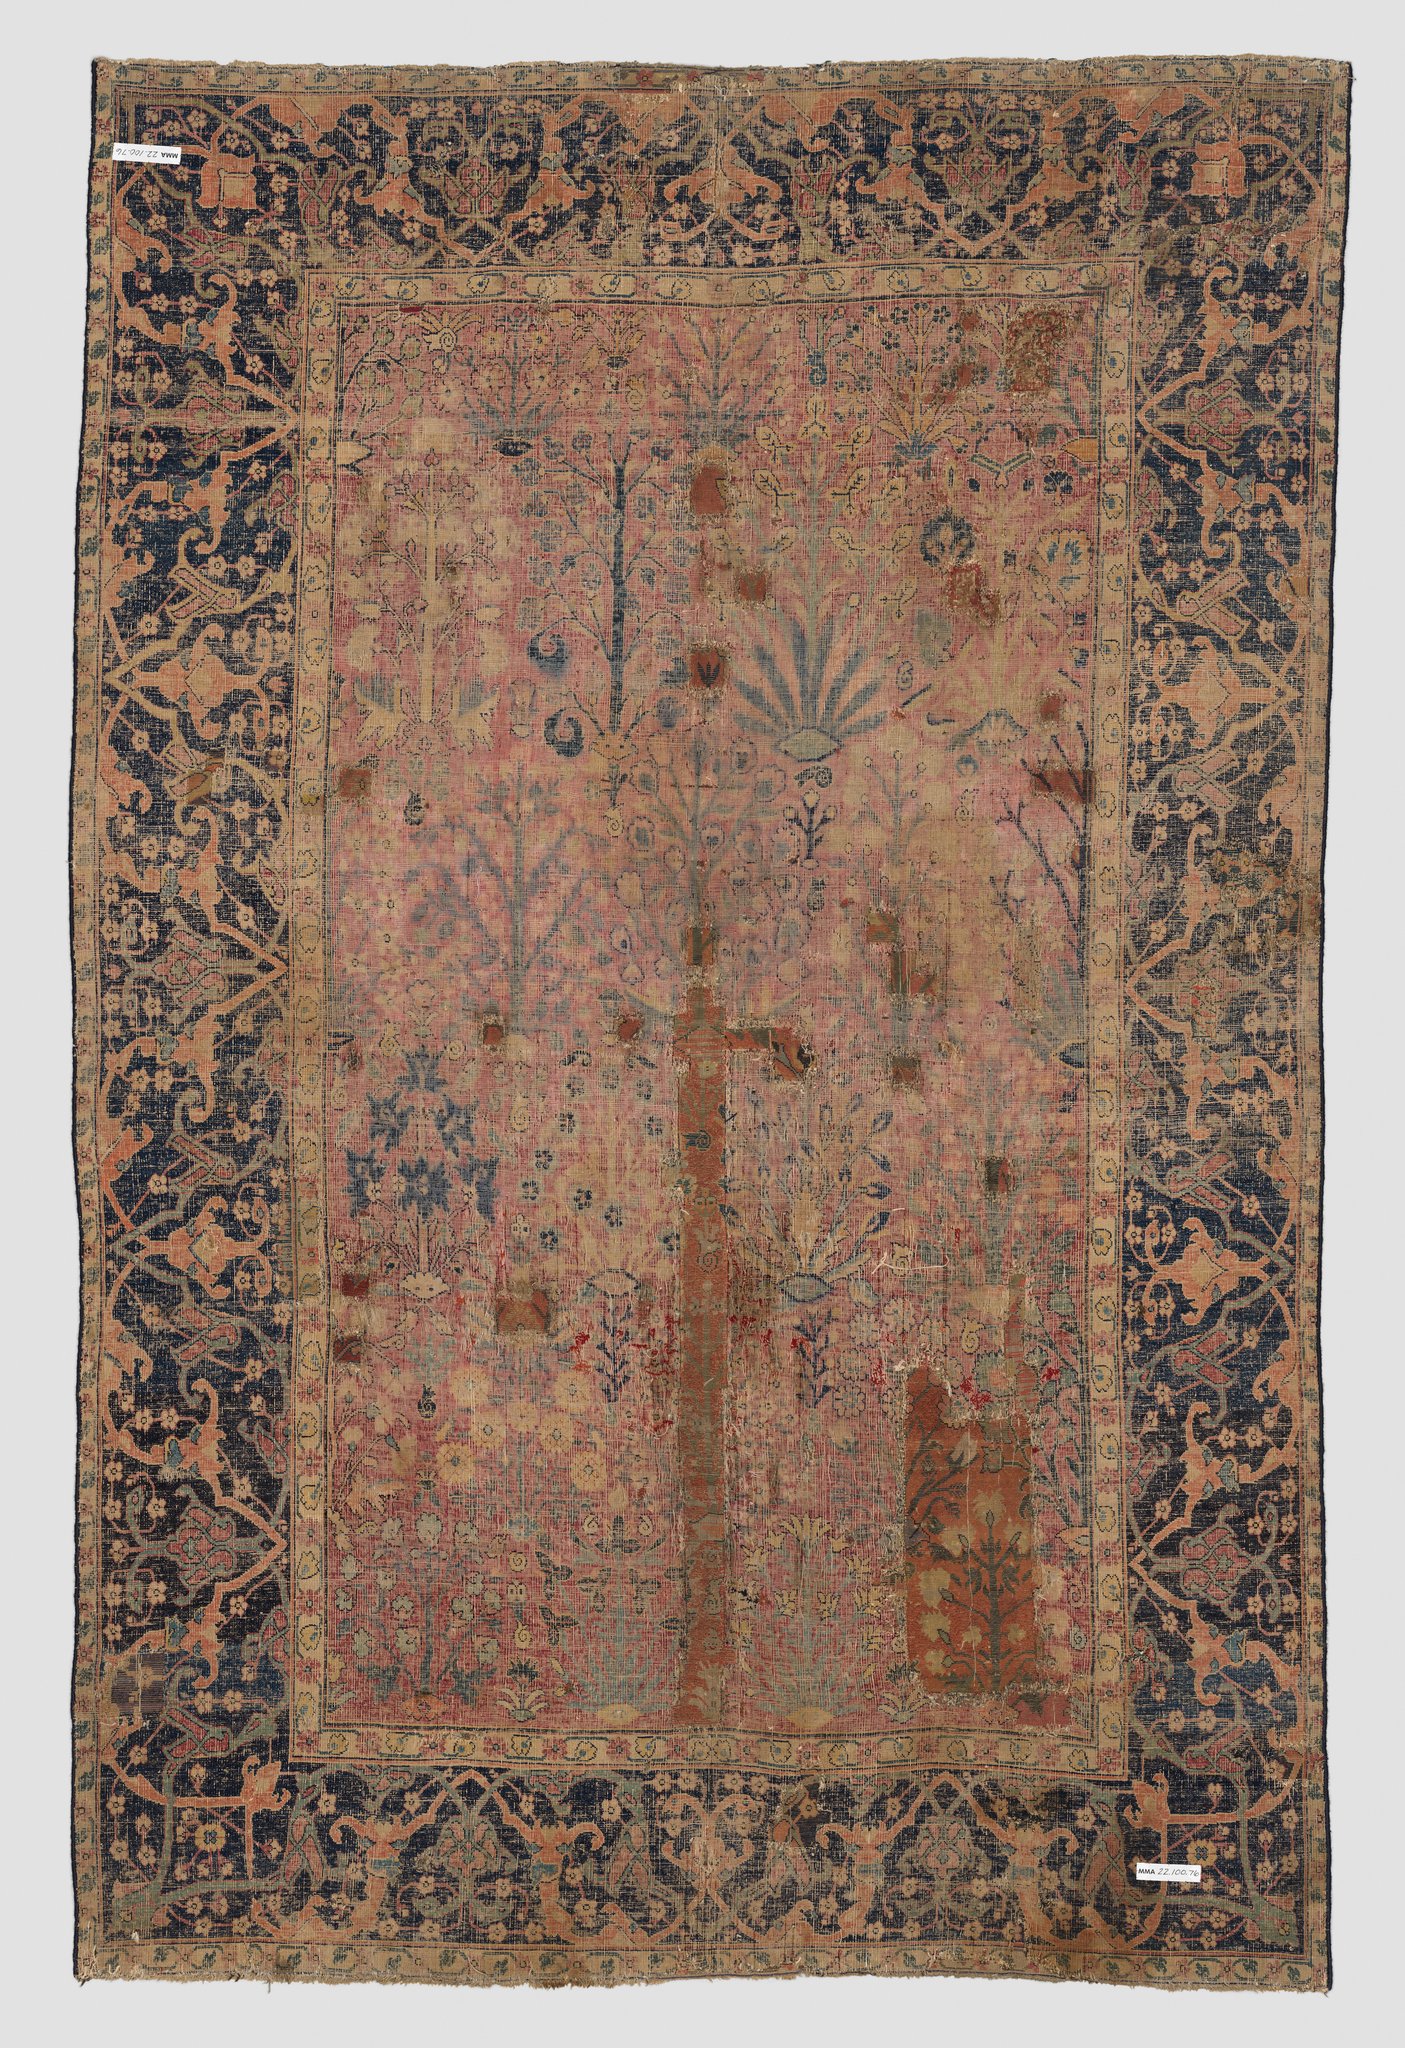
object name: carpet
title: Shrub Carpet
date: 1701-1733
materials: cotton, wool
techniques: asymmetrically knotted pile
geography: iran